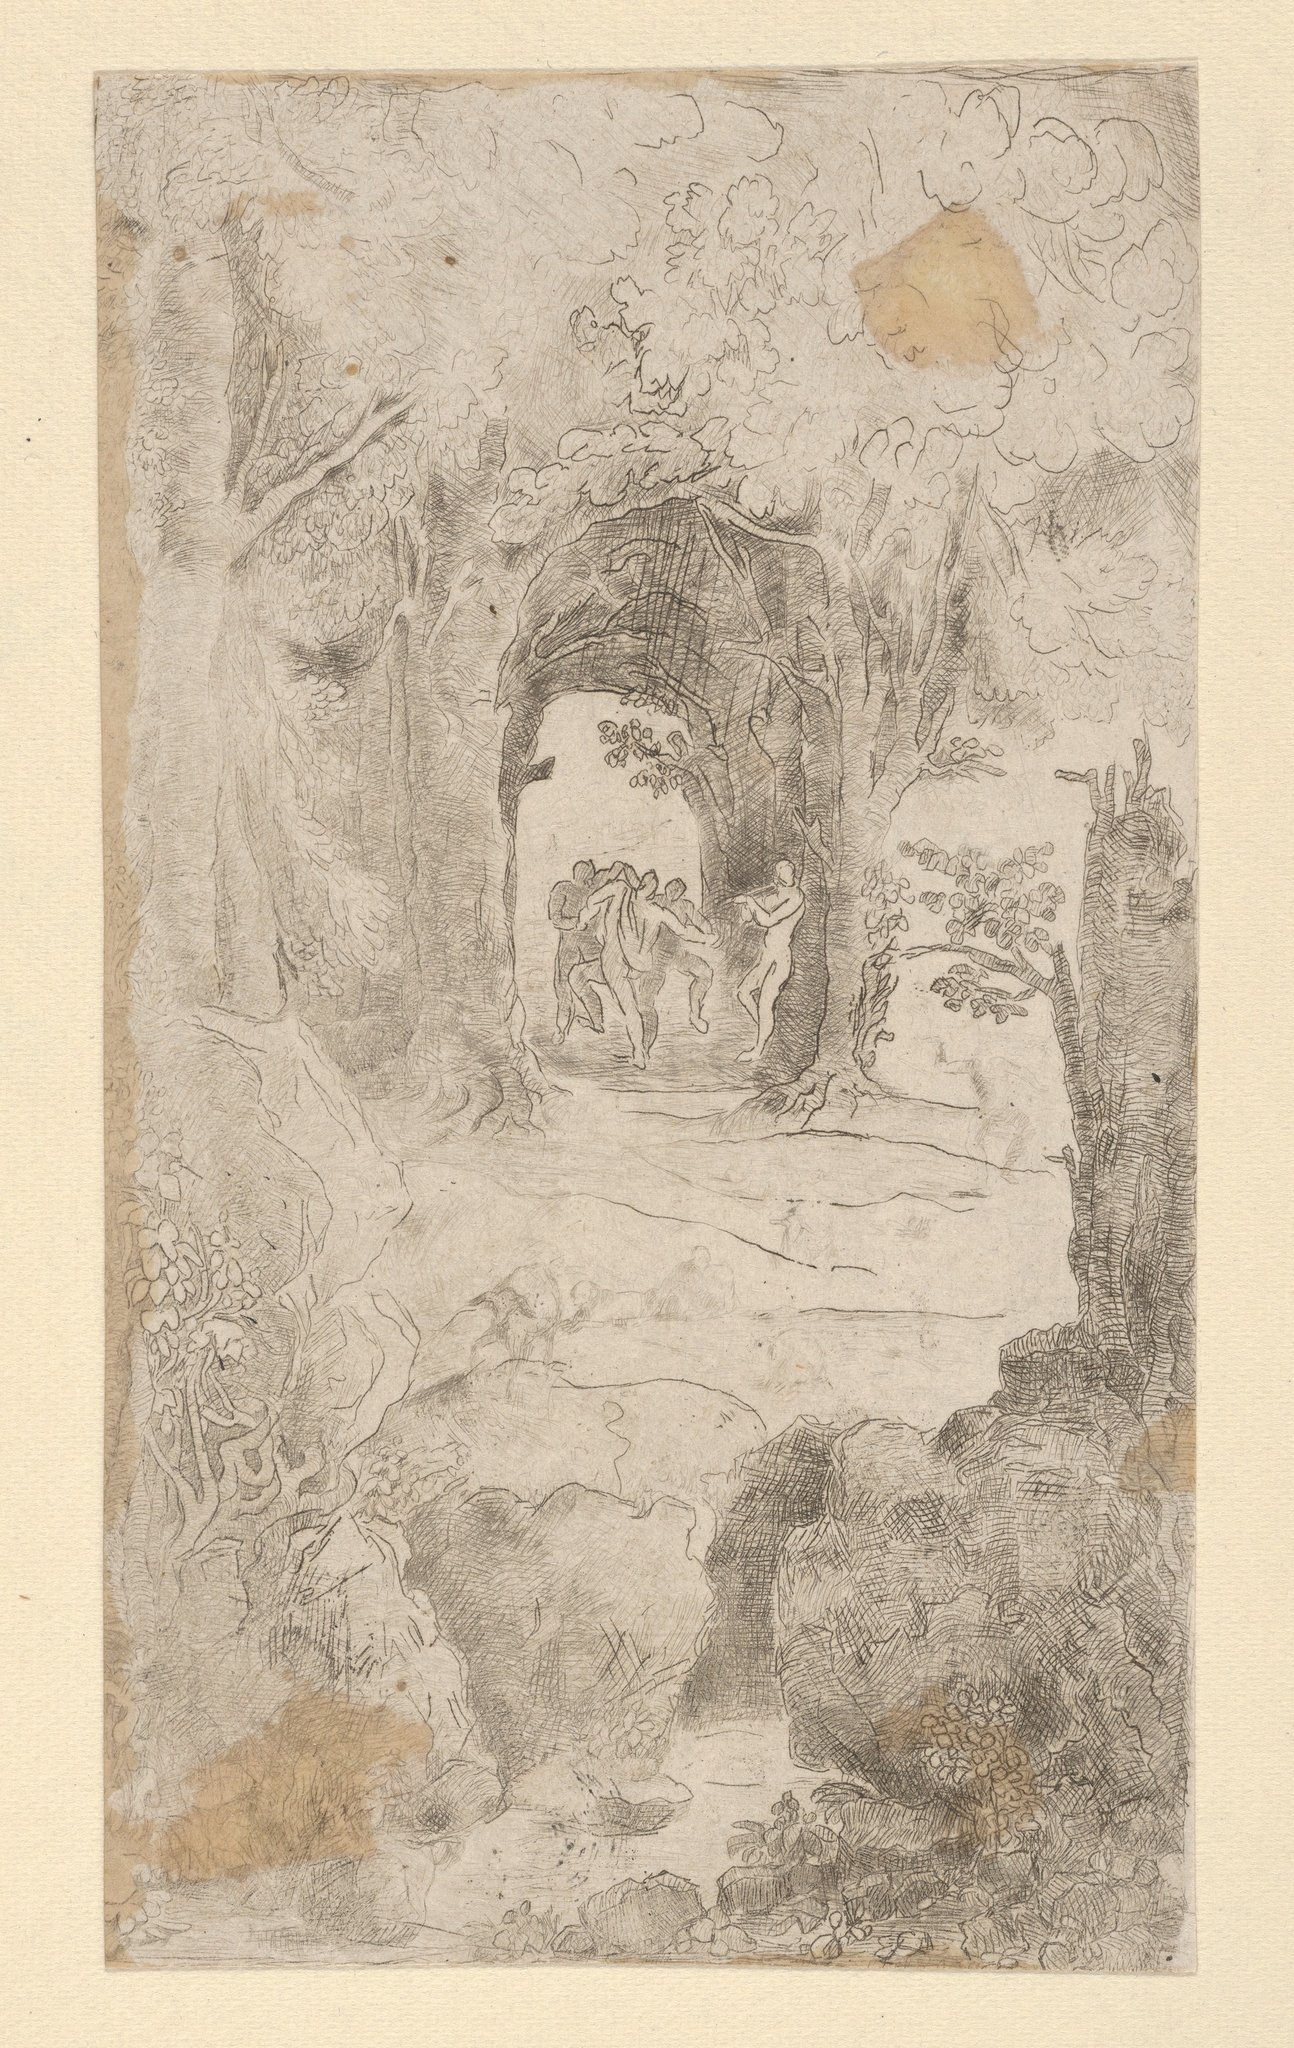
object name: print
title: Faunes Dansant (Dancing Fauns)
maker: rodolphe bresdin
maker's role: artist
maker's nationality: french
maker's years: 1822-1885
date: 1801-1900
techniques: etching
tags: dancing,fauns